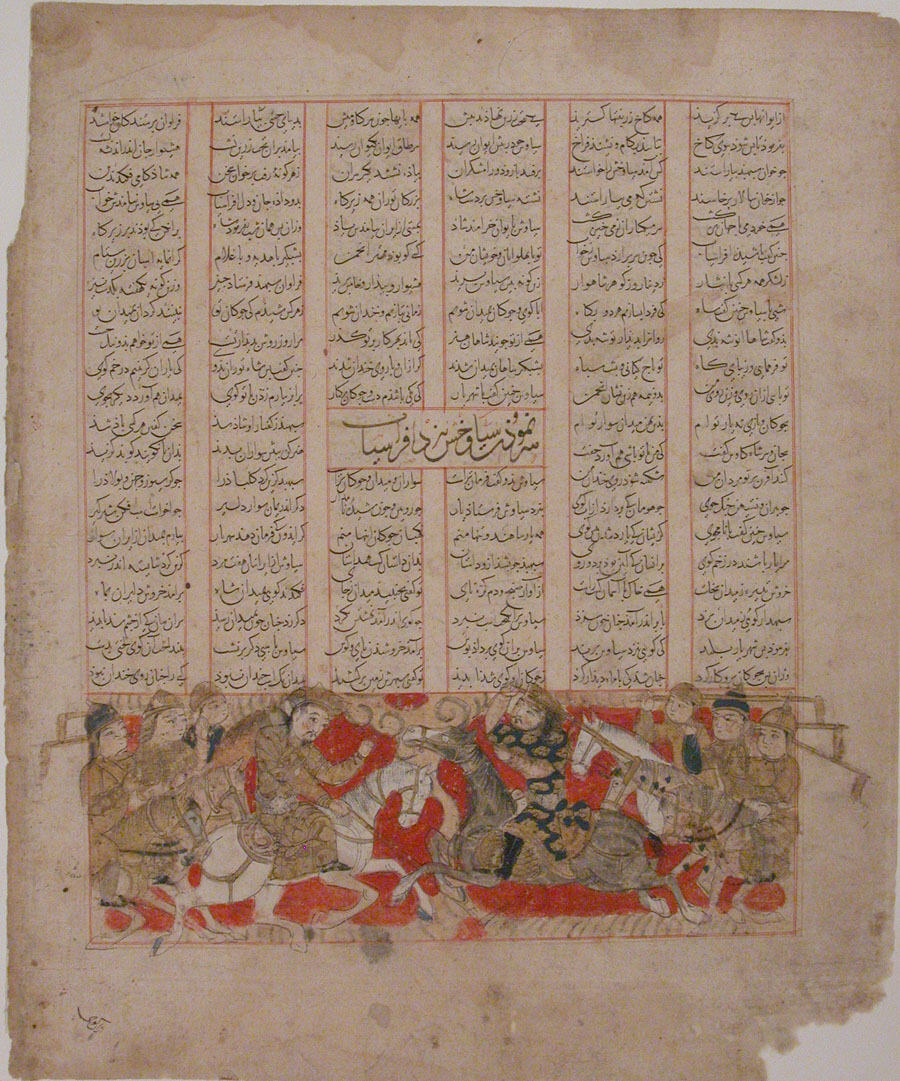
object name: folio from an illustrated manuscript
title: "Siyavush Displays his Skill at Polo before Afrasiyab," Folio from a Shahnama (Book of Kings)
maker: abu'l qasim firdausi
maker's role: author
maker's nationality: iranian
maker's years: 935-1020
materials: gold, ink, paper, watercolor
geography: iran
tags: poetry,men,horses